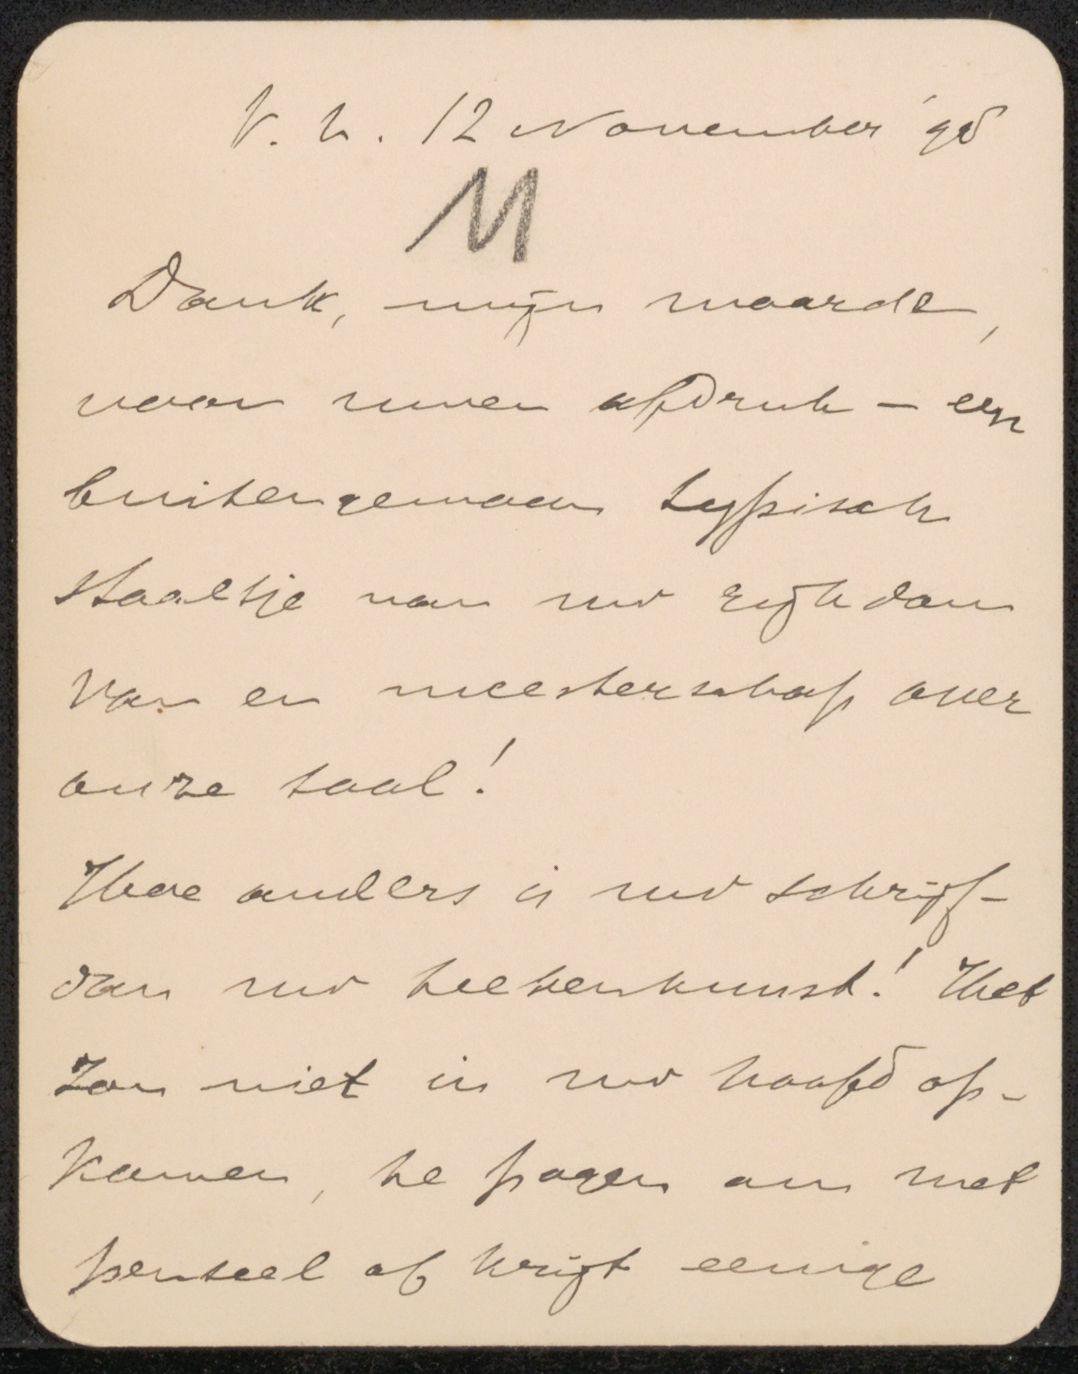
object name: letter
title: Brief aan Jan Veth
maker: jacob pieter moltzer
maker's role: jurist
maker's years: 1850-1907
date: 1898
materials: ink, paper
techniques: pen, writing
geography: the hague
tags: dordrecht, amsterdam, painter, print maker, draughtsman, designer, jan veth, printed matter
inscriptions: collector's mark: ‘RPK’